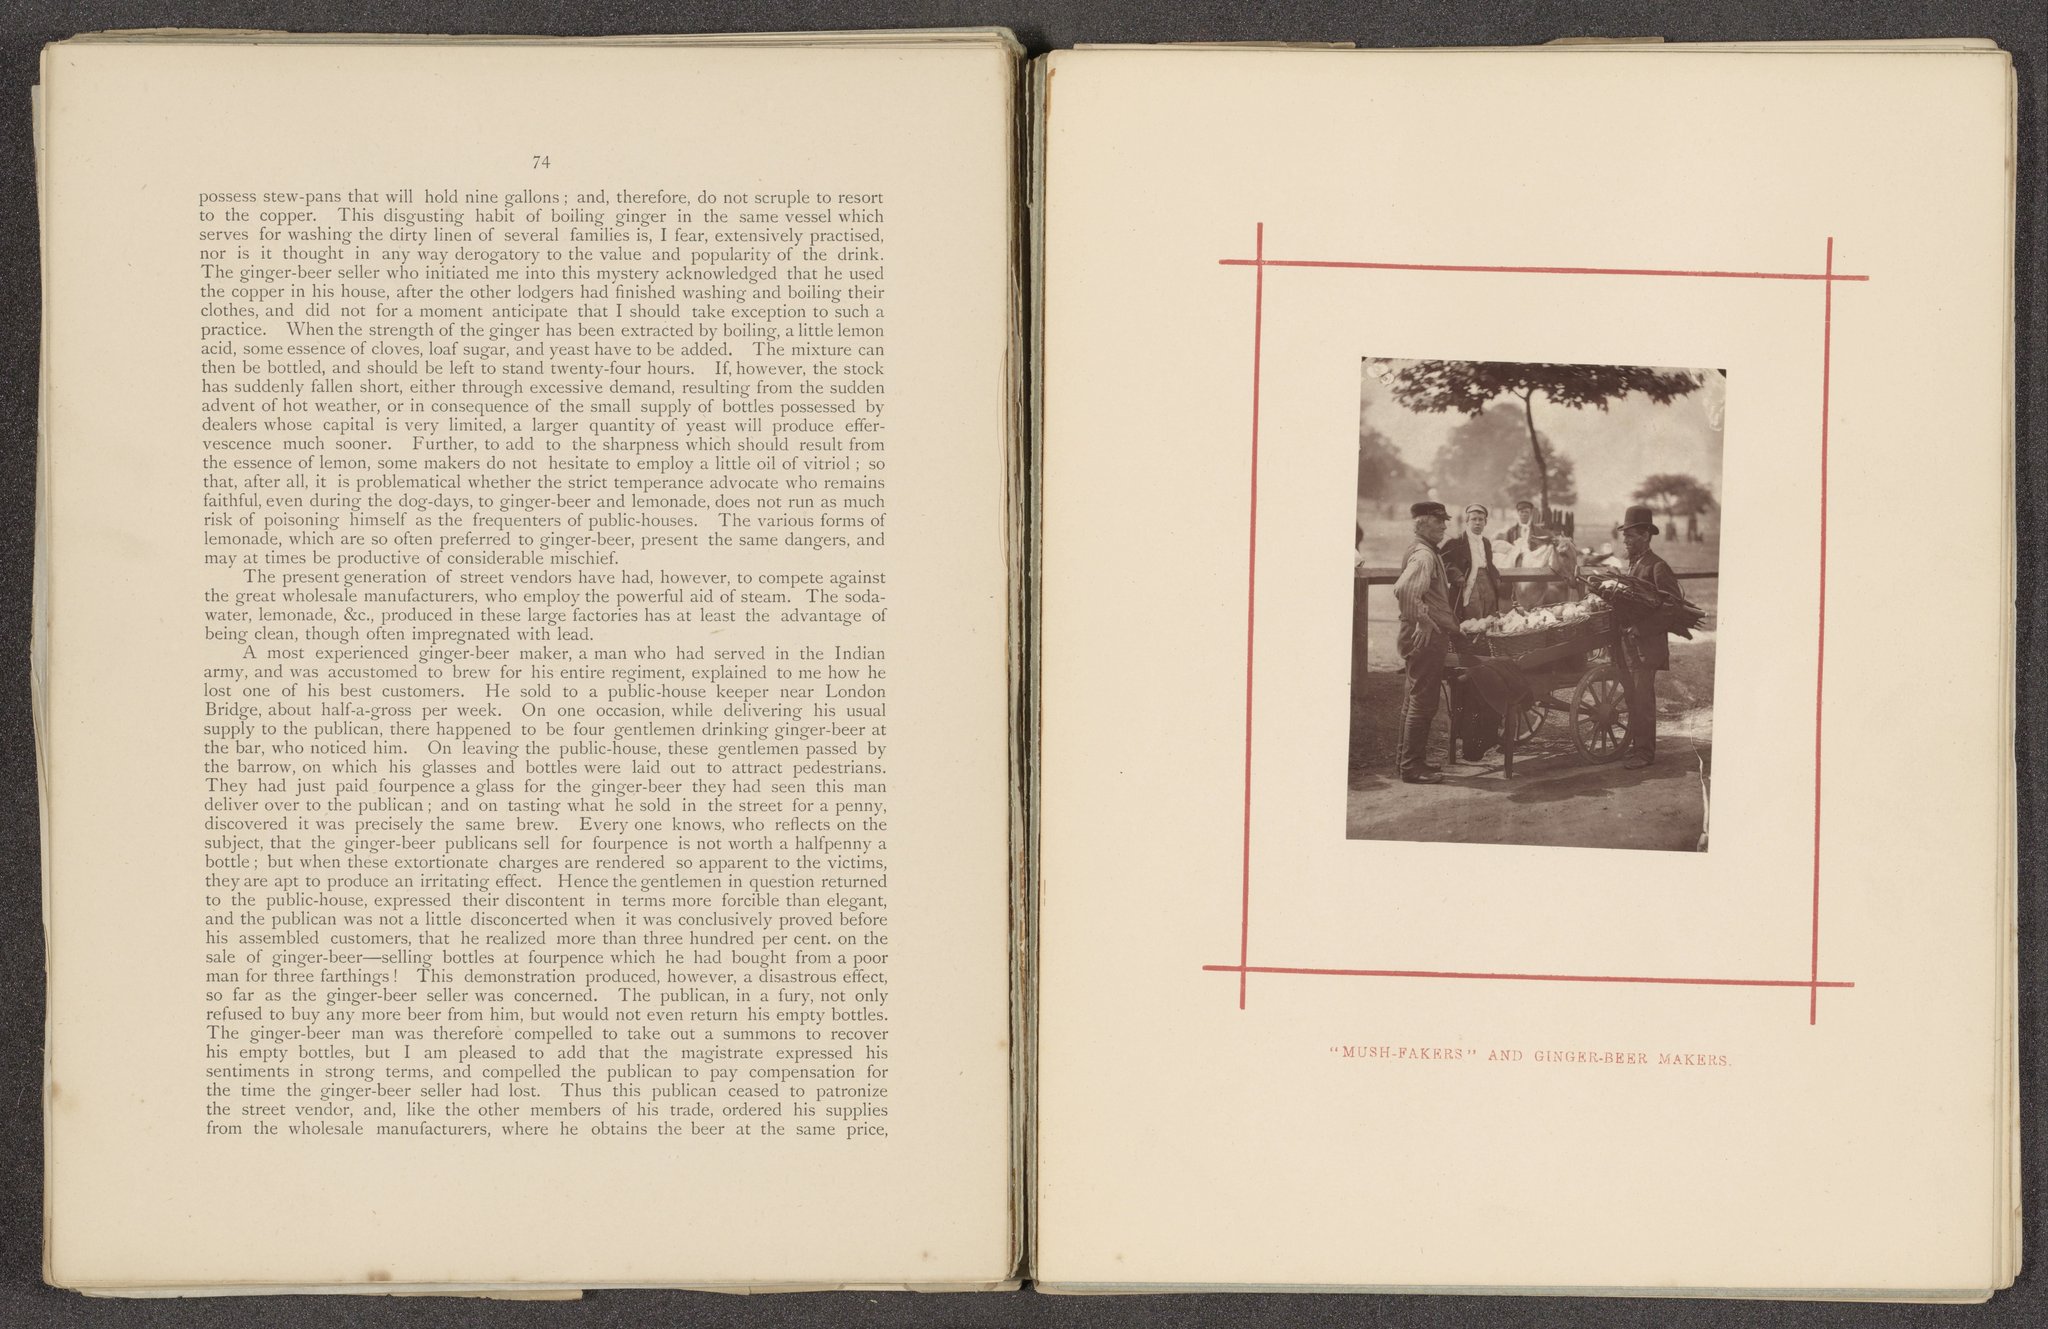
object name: photomechanical print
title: "Mush-fakers" and ginger-beer makers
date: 1876-1877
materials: paper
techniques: woodburytype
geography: london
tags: street-trader, umbrella, beer, ale, london